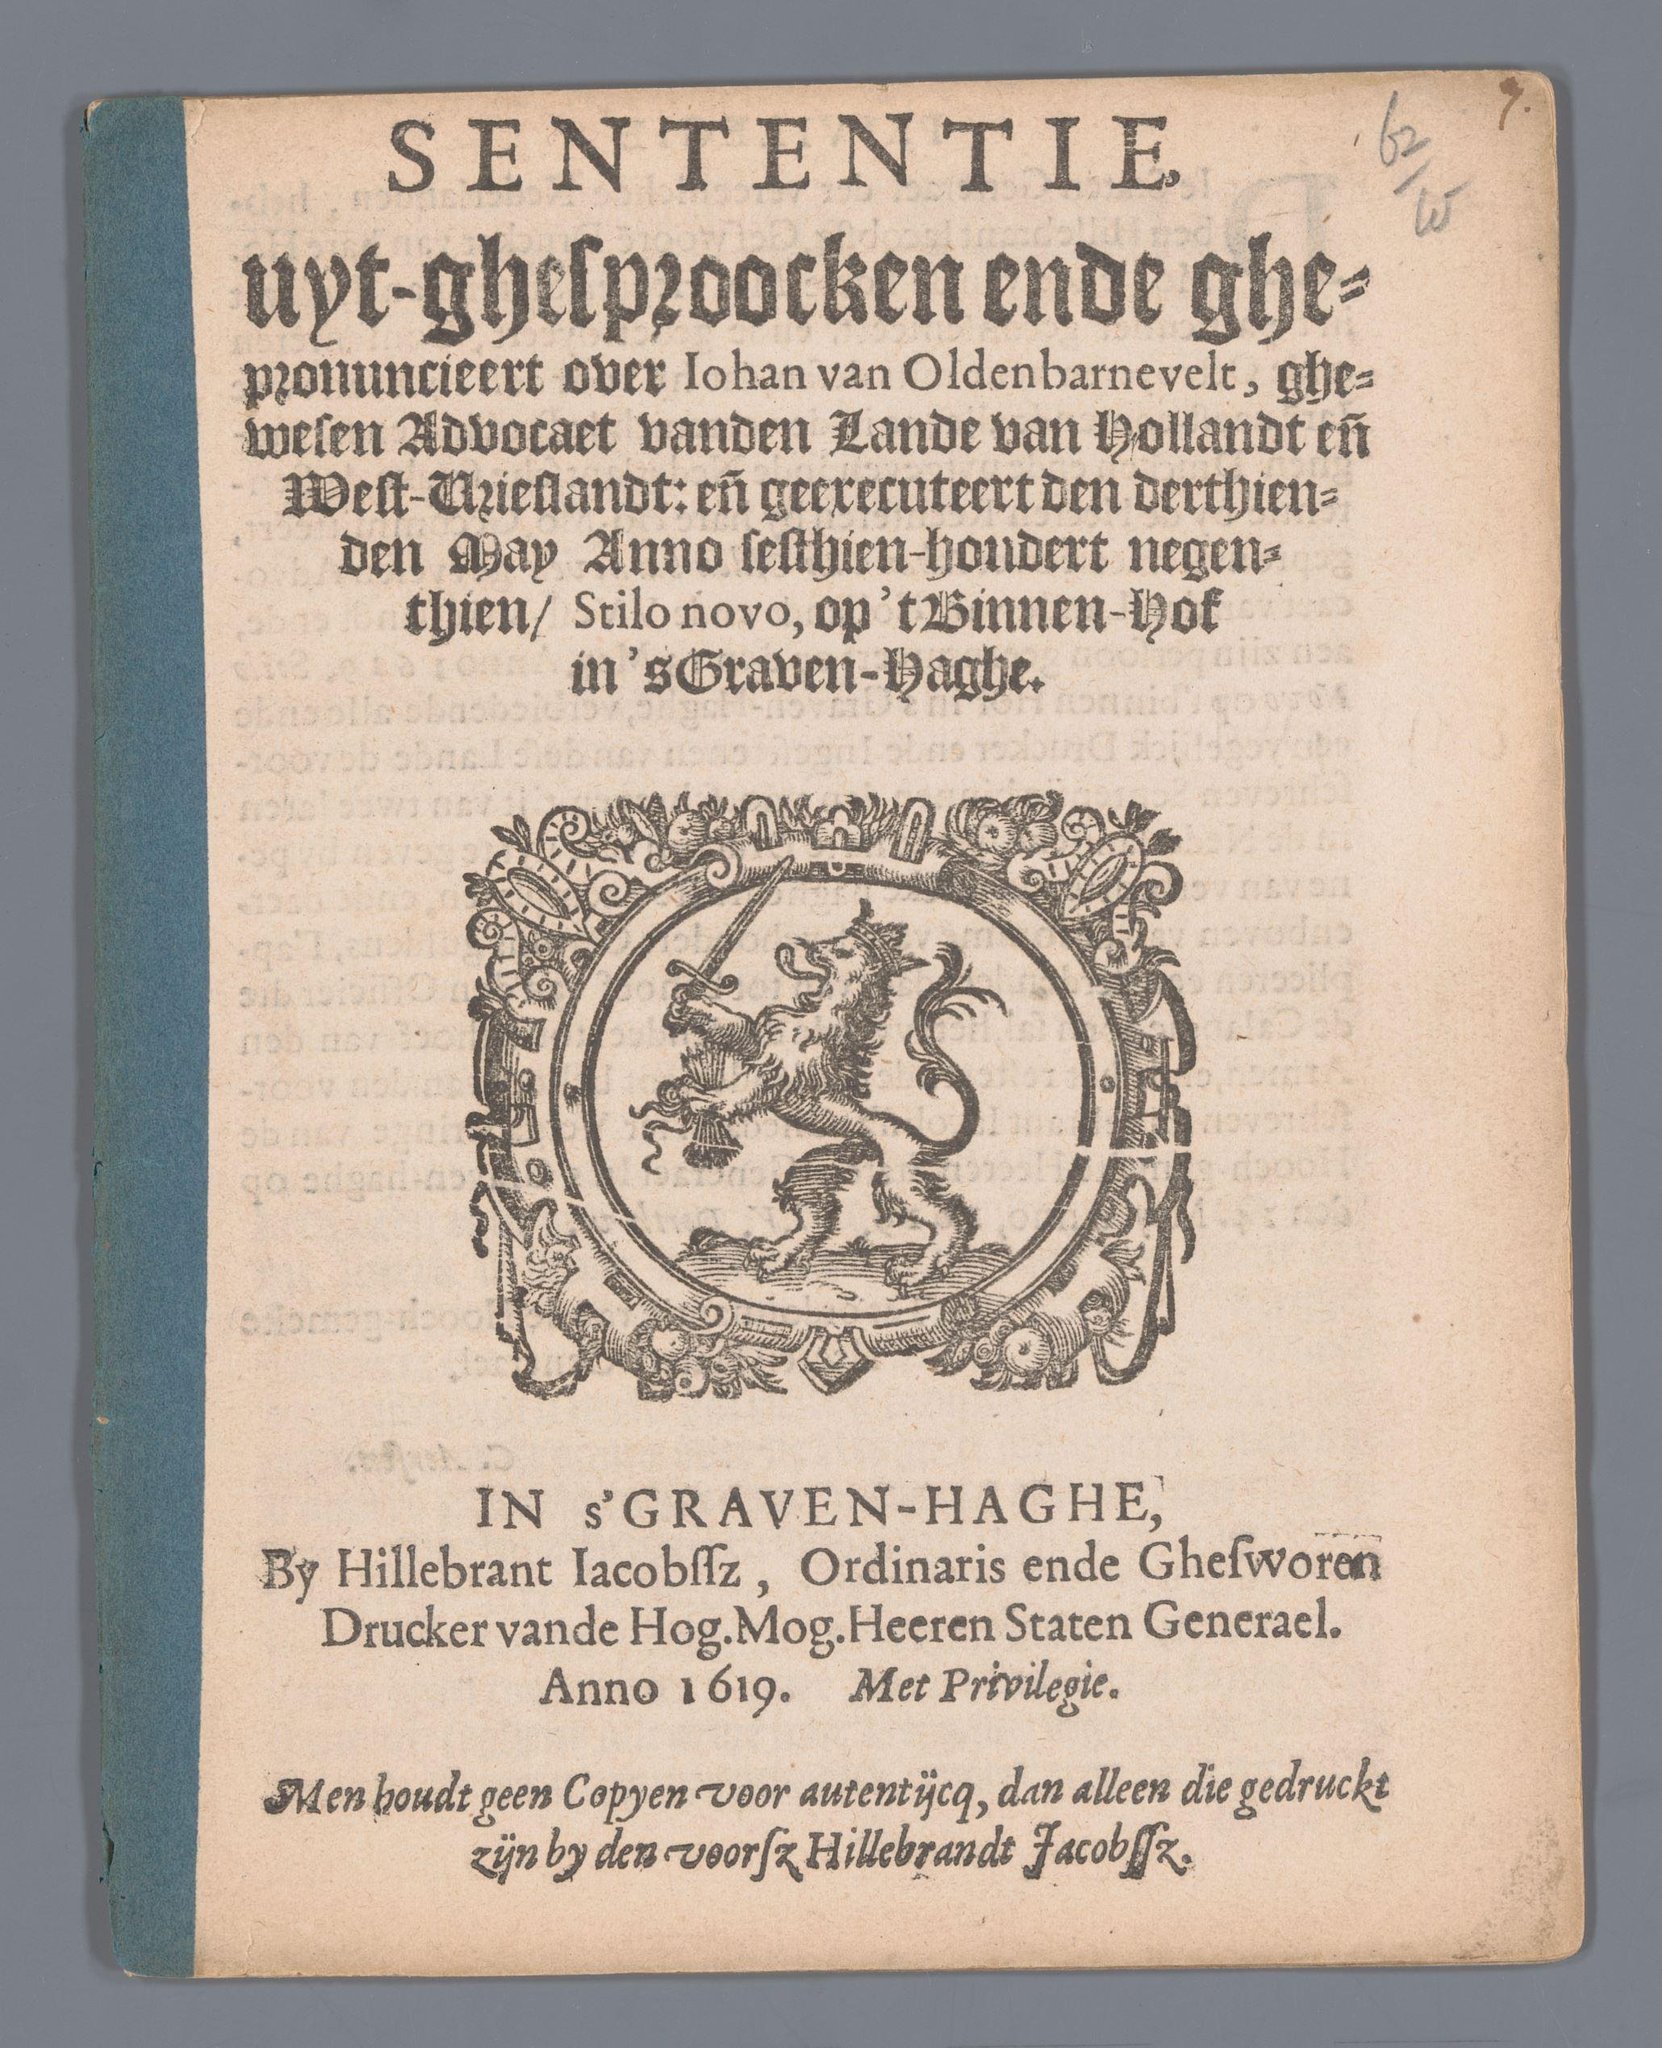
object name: pamphlet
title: Sententie uyt-ghesproocken ende ghepronuncieert over Iohan van Oldenbarnevelt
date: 1619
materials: paper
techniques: printing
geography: the hague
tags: the hague, johan van oldenbarnevelt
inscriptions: date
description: Conviction of Johan van Oldenbarnevelt. After the trial of Johan van Oldenbarnevelt, the States General published and distributed the text of the judgment. Van Oldenbarnevelt had played a key role in the religious struggle between the moderates and the extremists. Within two days of the pronouncement of the verdict the government authorised the publication of the 'sentence' in Dutch, French and Latin. A testimony of the government's recognition of the important role that pamphlets played.